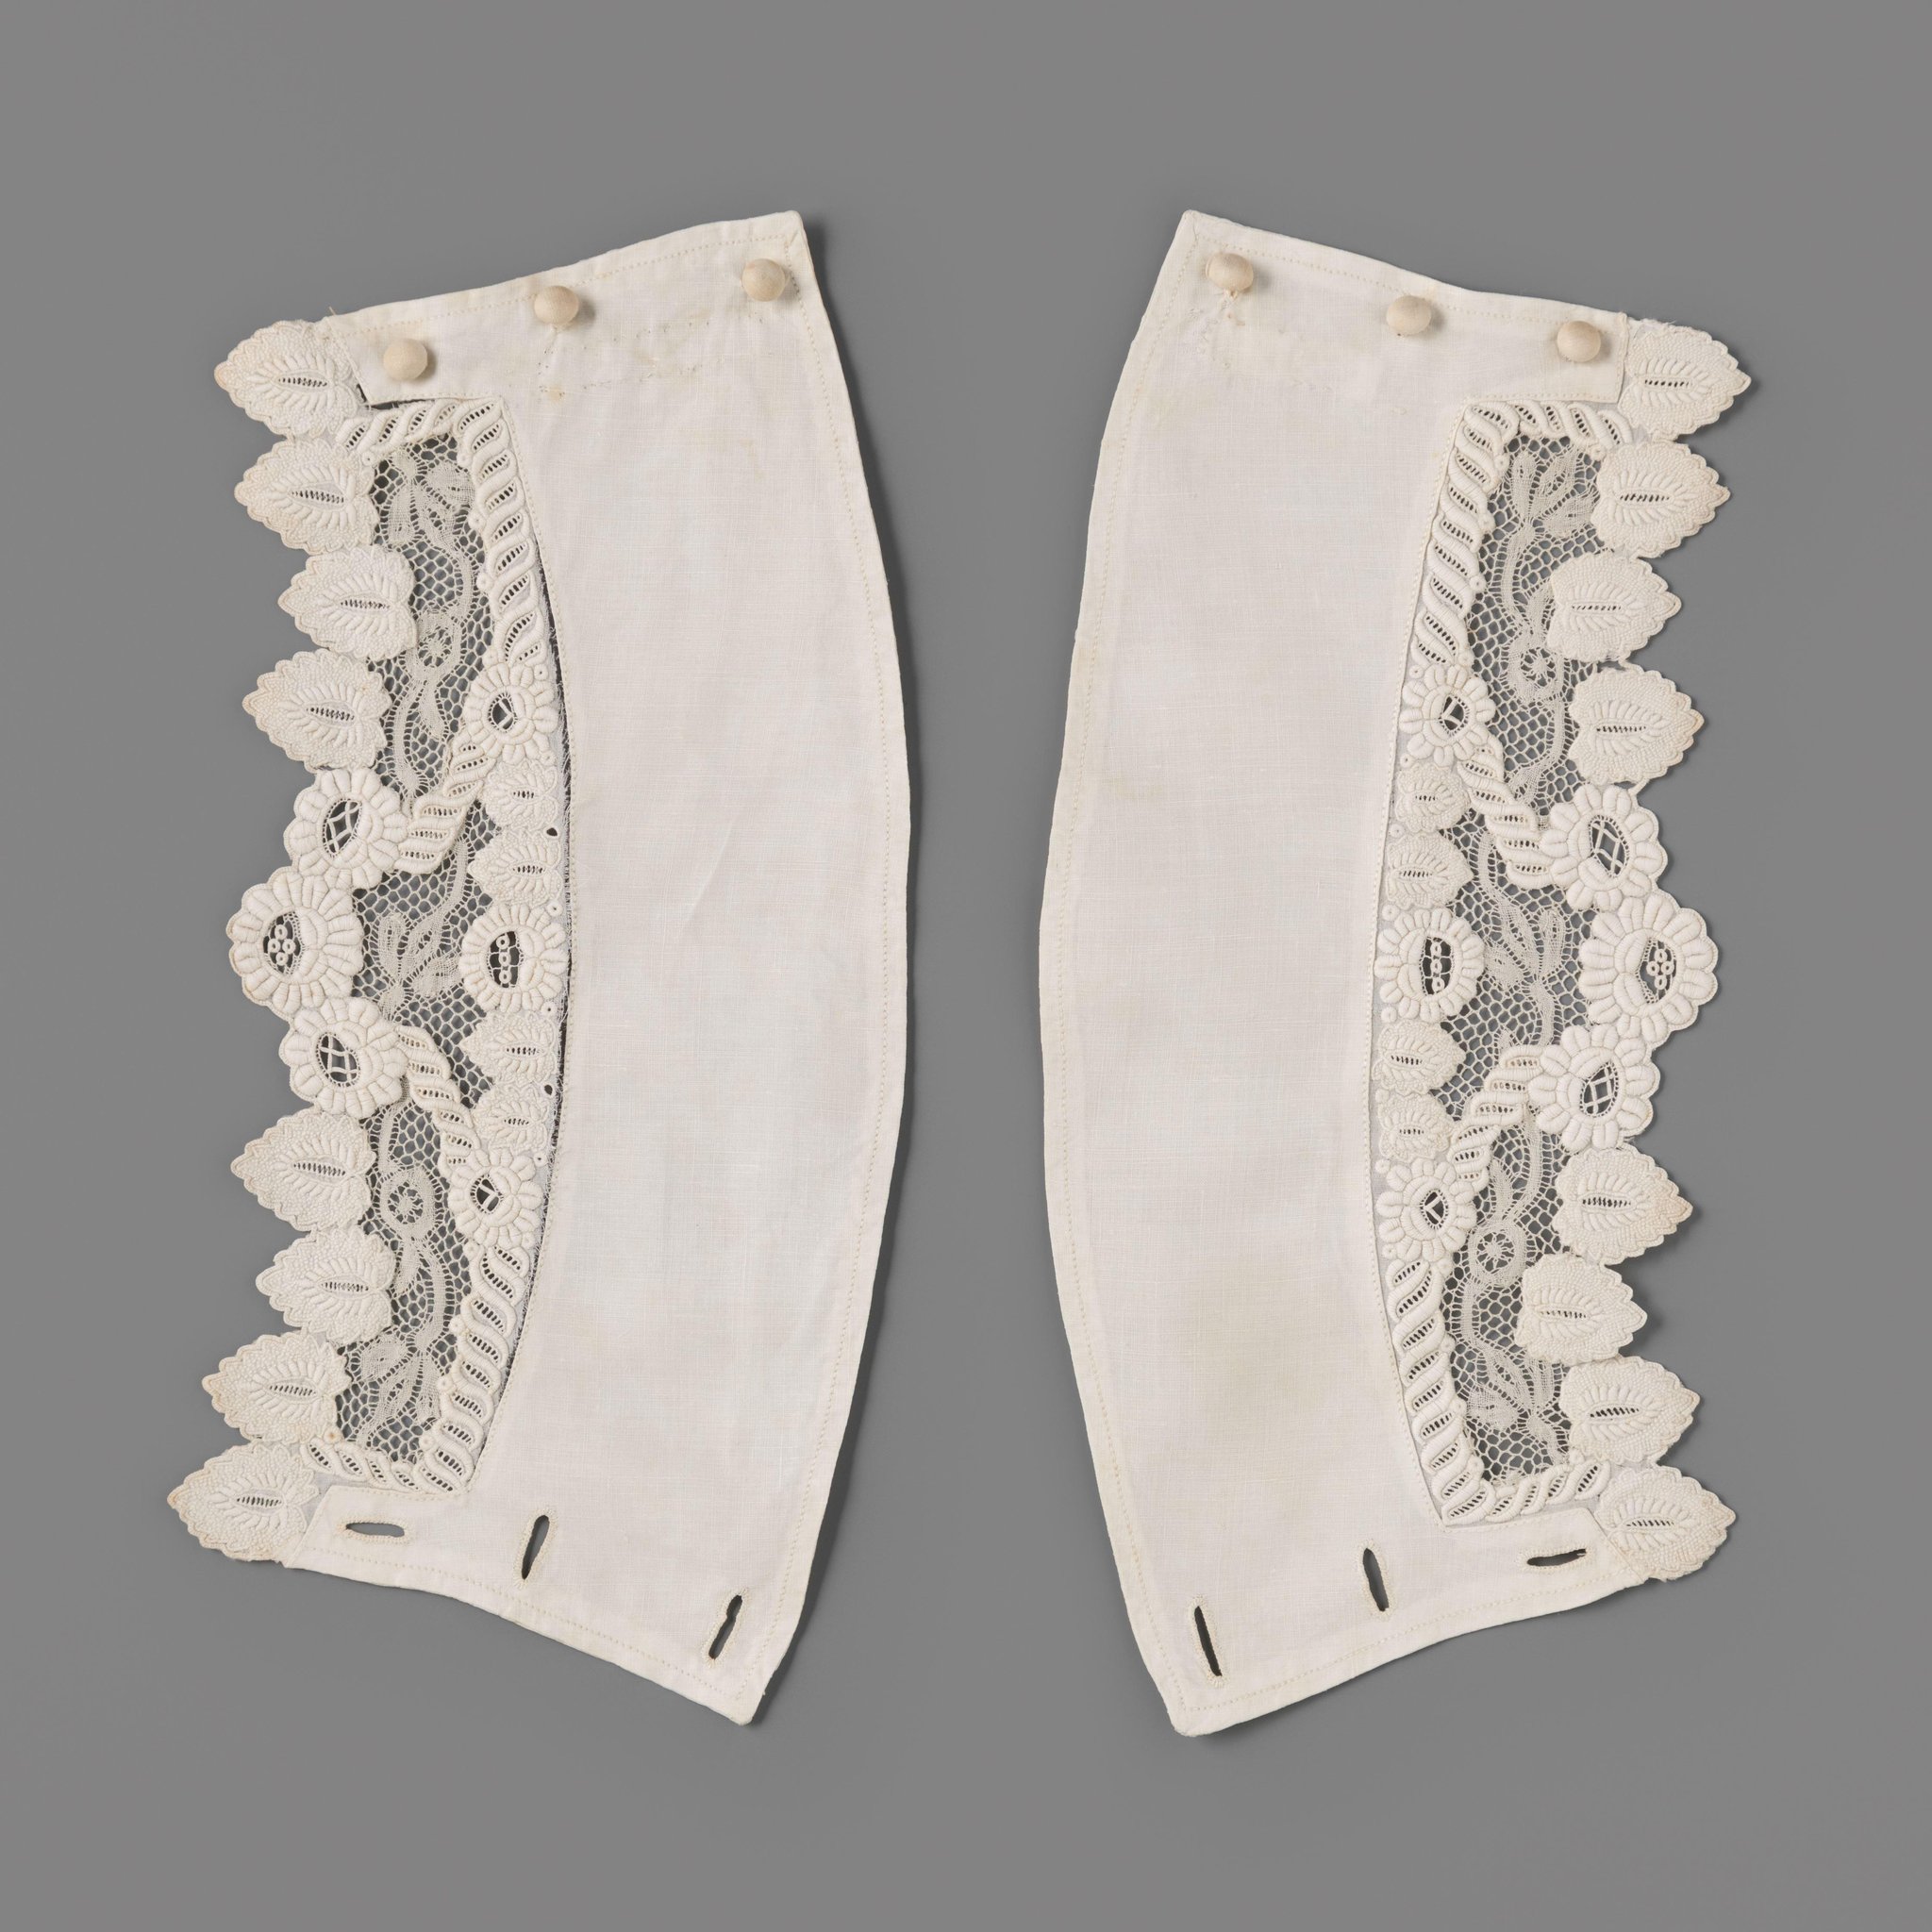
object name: womenswear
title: Manchet van linnen batist versierd met borduurwerk en kloskant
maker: Anonymous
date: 1890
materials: linen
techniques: lace, embroidery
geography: western europe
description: Manchet van linnen batist waaraan een strook is bevestigd die bestaat uit een combinatie van witwerk in de vorm van bloemen en bladeren met kloskant. De manchet kan worden gesloten door middel van drie met batist beklede knopen.